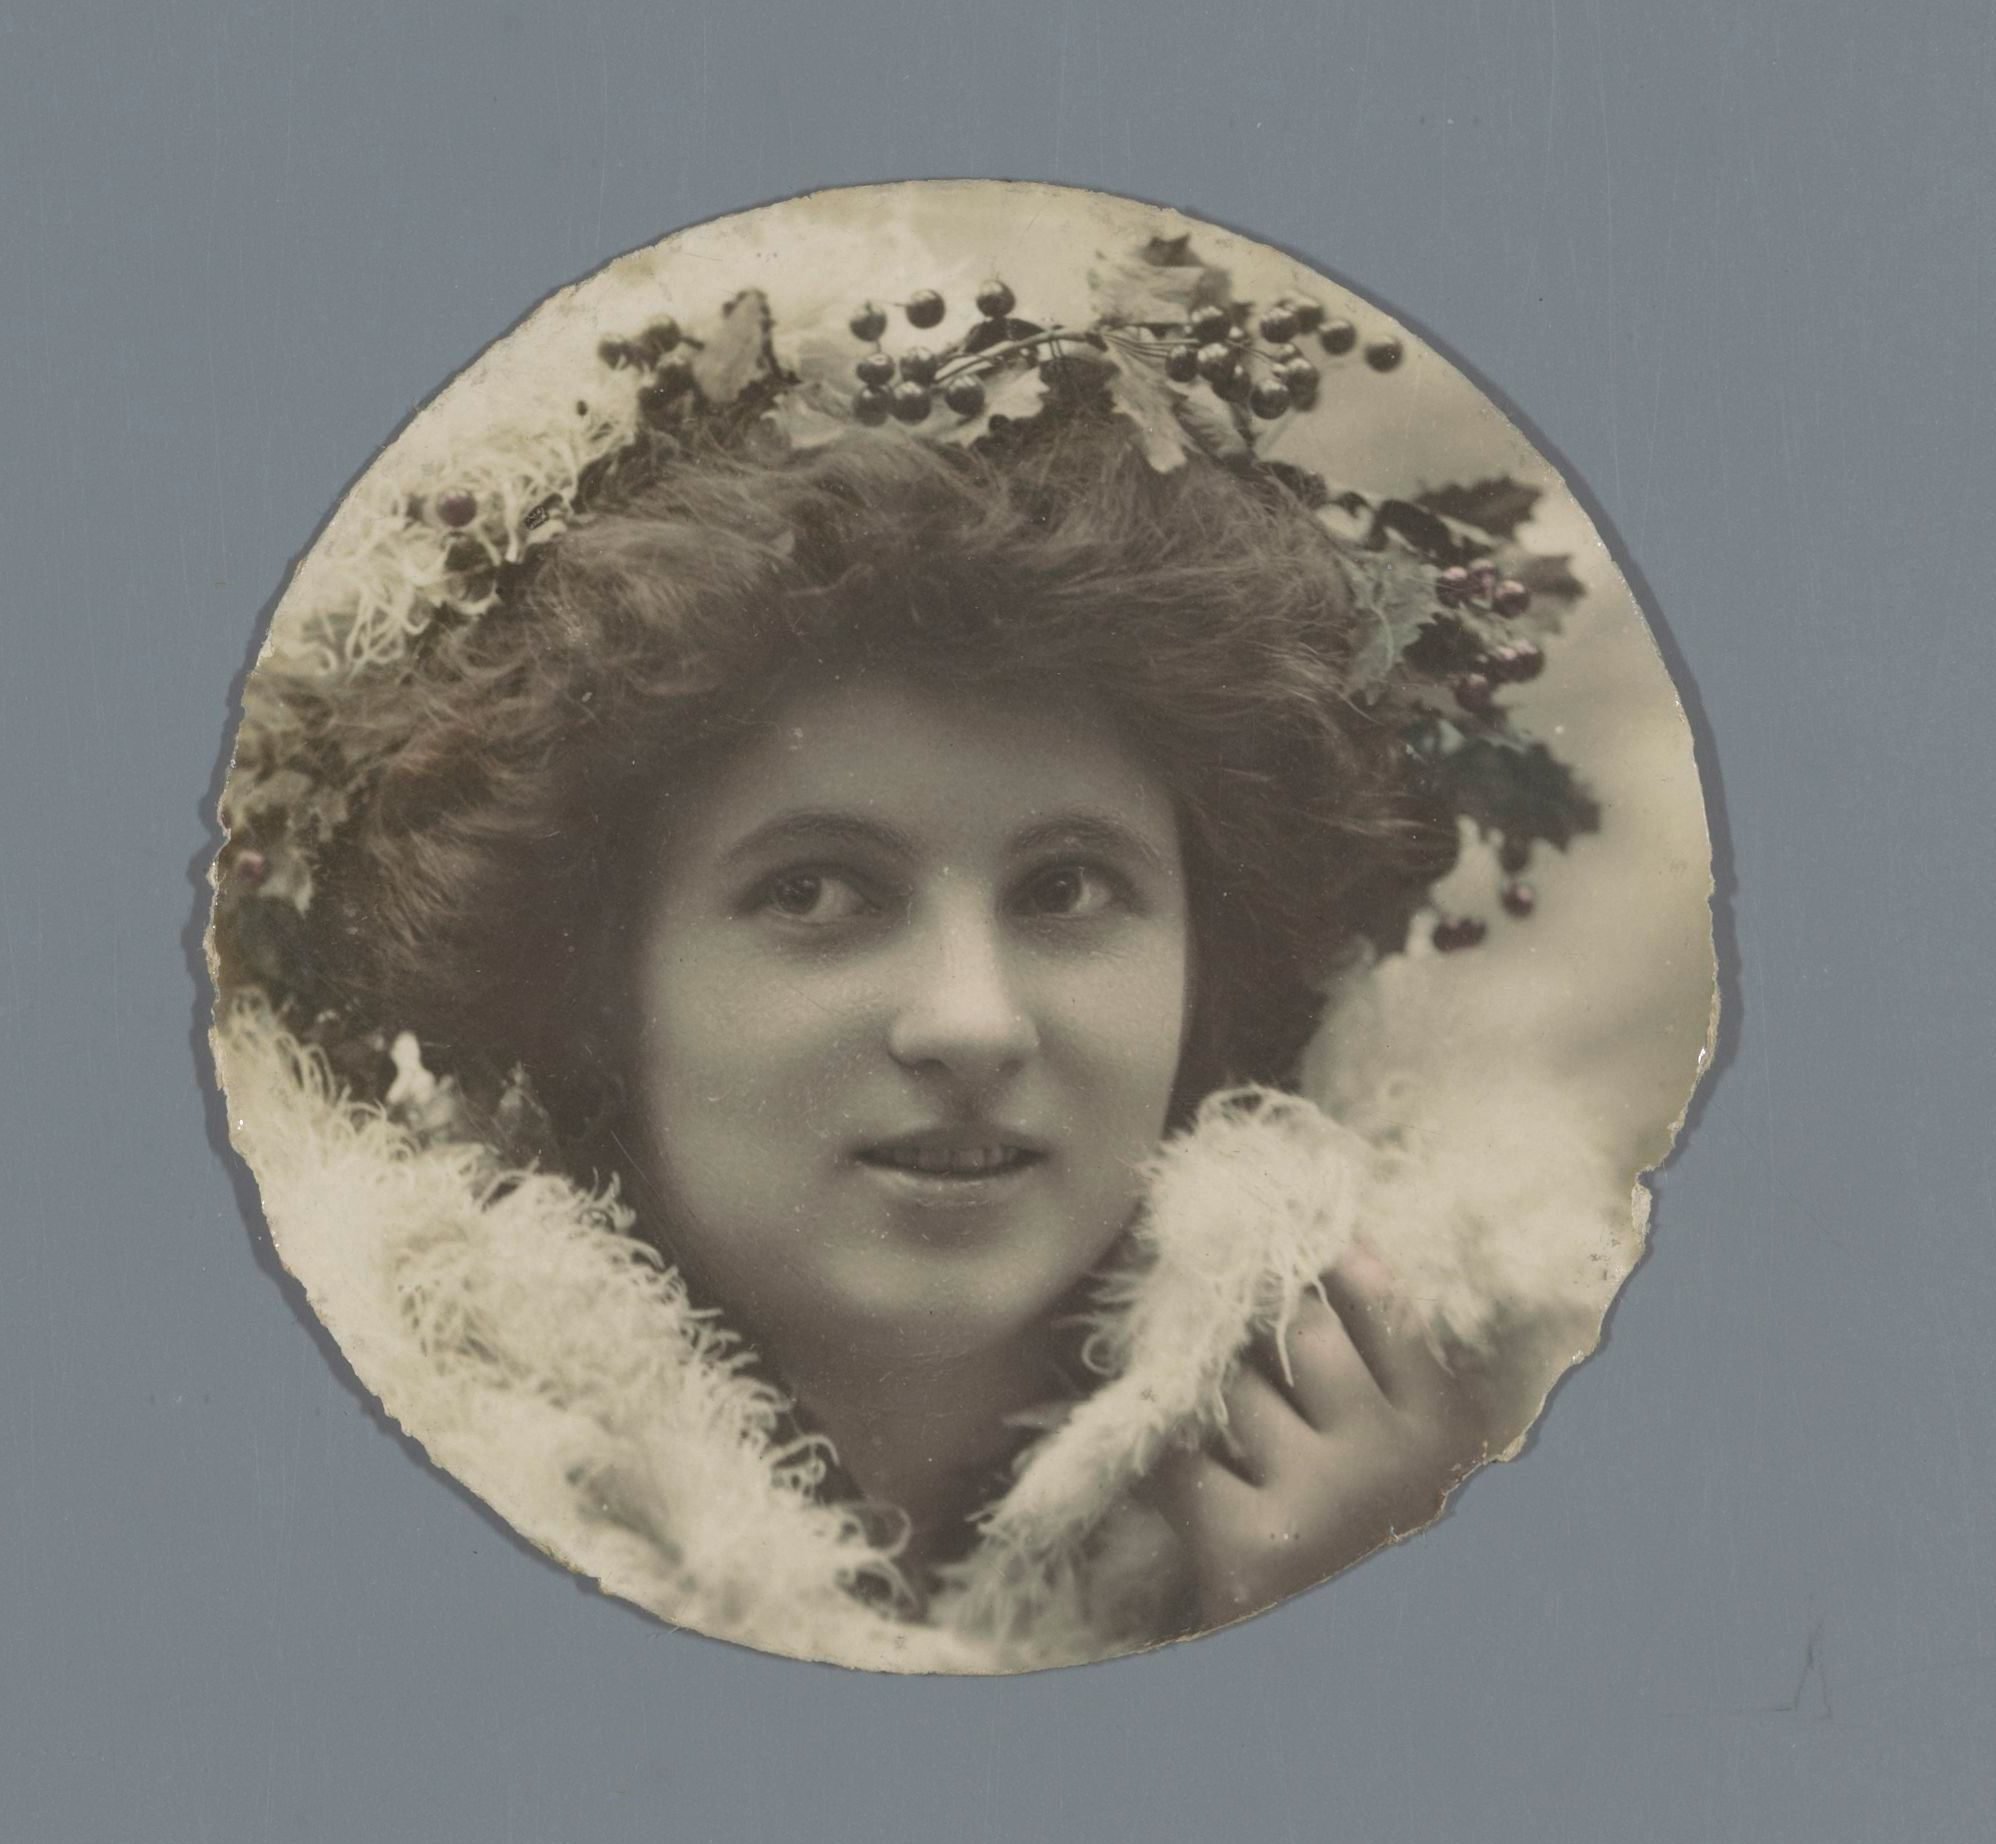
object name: photograph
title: Portret van een onbekende vrouw met een hulsttak in het haar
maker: Anonymous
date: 1910-1920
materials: cardboard, photographic support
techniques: albumen print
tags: adult woman, plants and herbs: holly